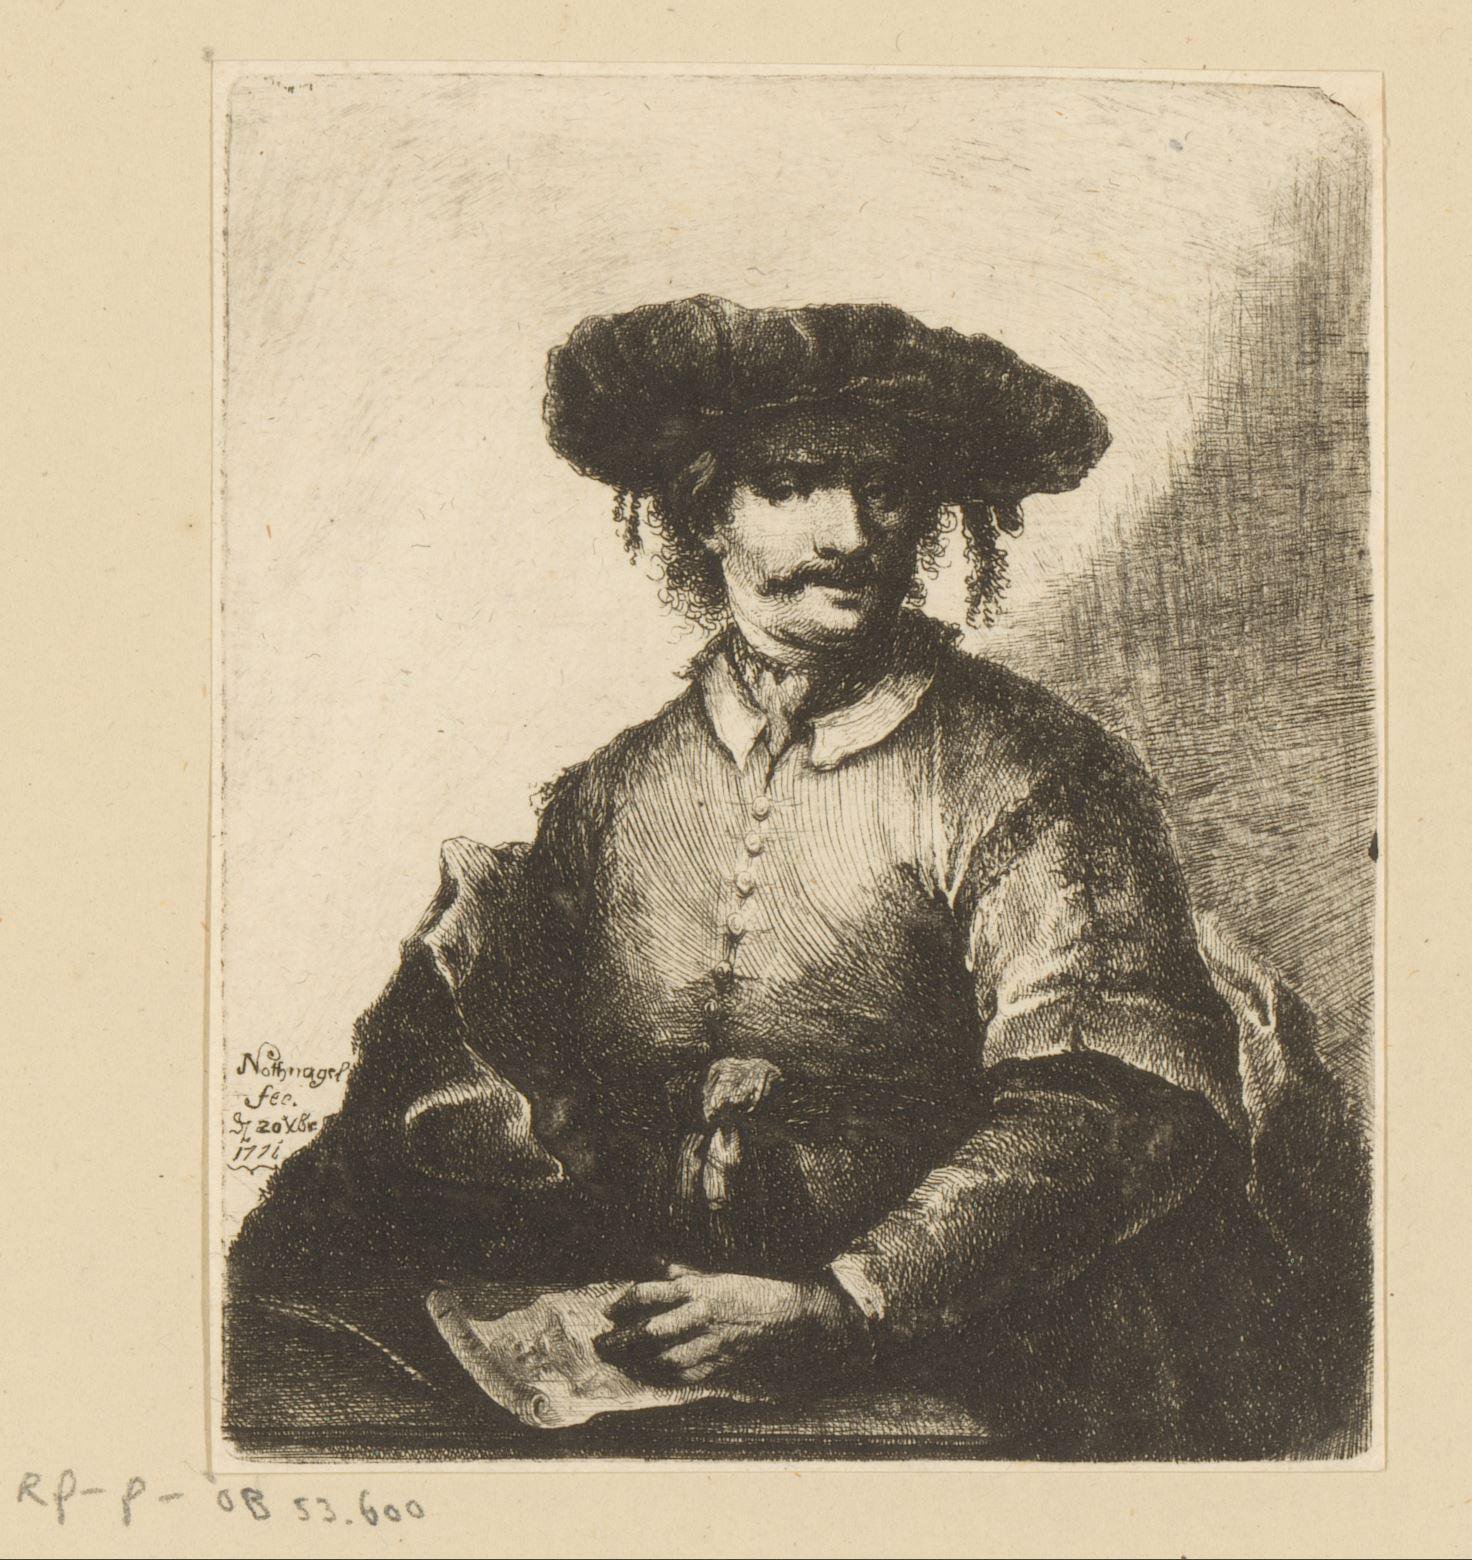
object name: print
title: Portret van een onbekende kunstenaar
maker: johann andreas benjamin nothnagel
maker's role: print maker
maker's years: 1729-1804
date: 1771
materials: paper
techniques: drypoint, etching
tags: portrait, self-portrait of artist, tools, implements of draughtsman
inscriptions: collector's mark: Lugt 240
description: Kunstenaar tekenend op een vel papier waarop een portret is afgebeeld.